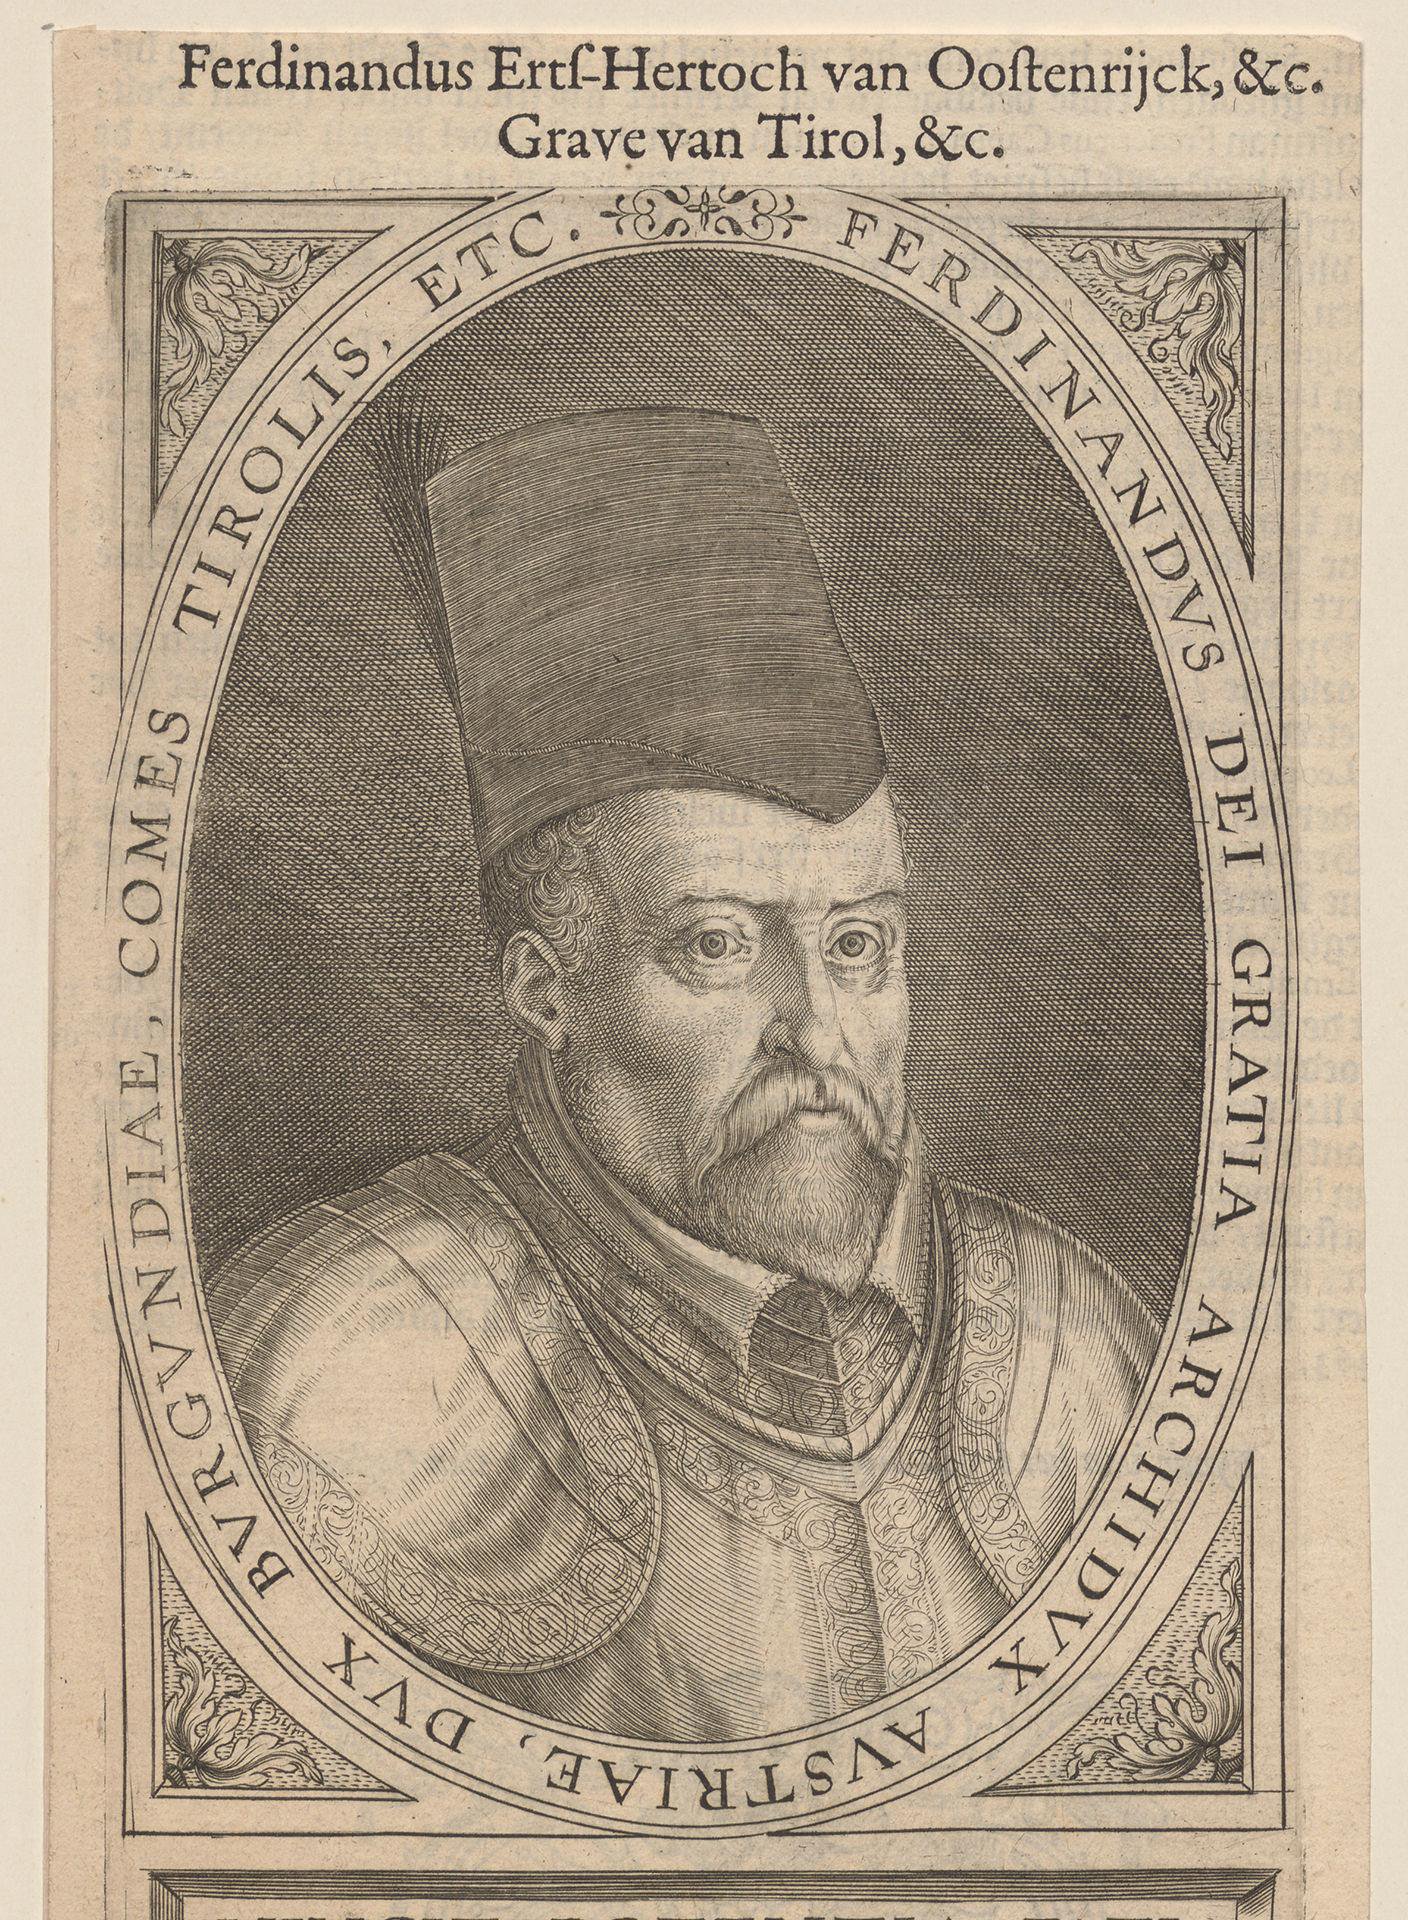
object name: print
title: Portret van Ferdinand II van Tirol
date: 1617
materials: paper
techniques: engraving, letterpress printing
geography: amsterdam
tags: ferdinand ii van tirol, historical persons, knighthood order of the golden fleece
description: Prent uit: Tooneel der beroemder hertogen princen graven ende krygs-helden van christenrijck binnen deze drij laetste eeuwen. Delft: Nicolaes de Clerck, 1617, p. 148.